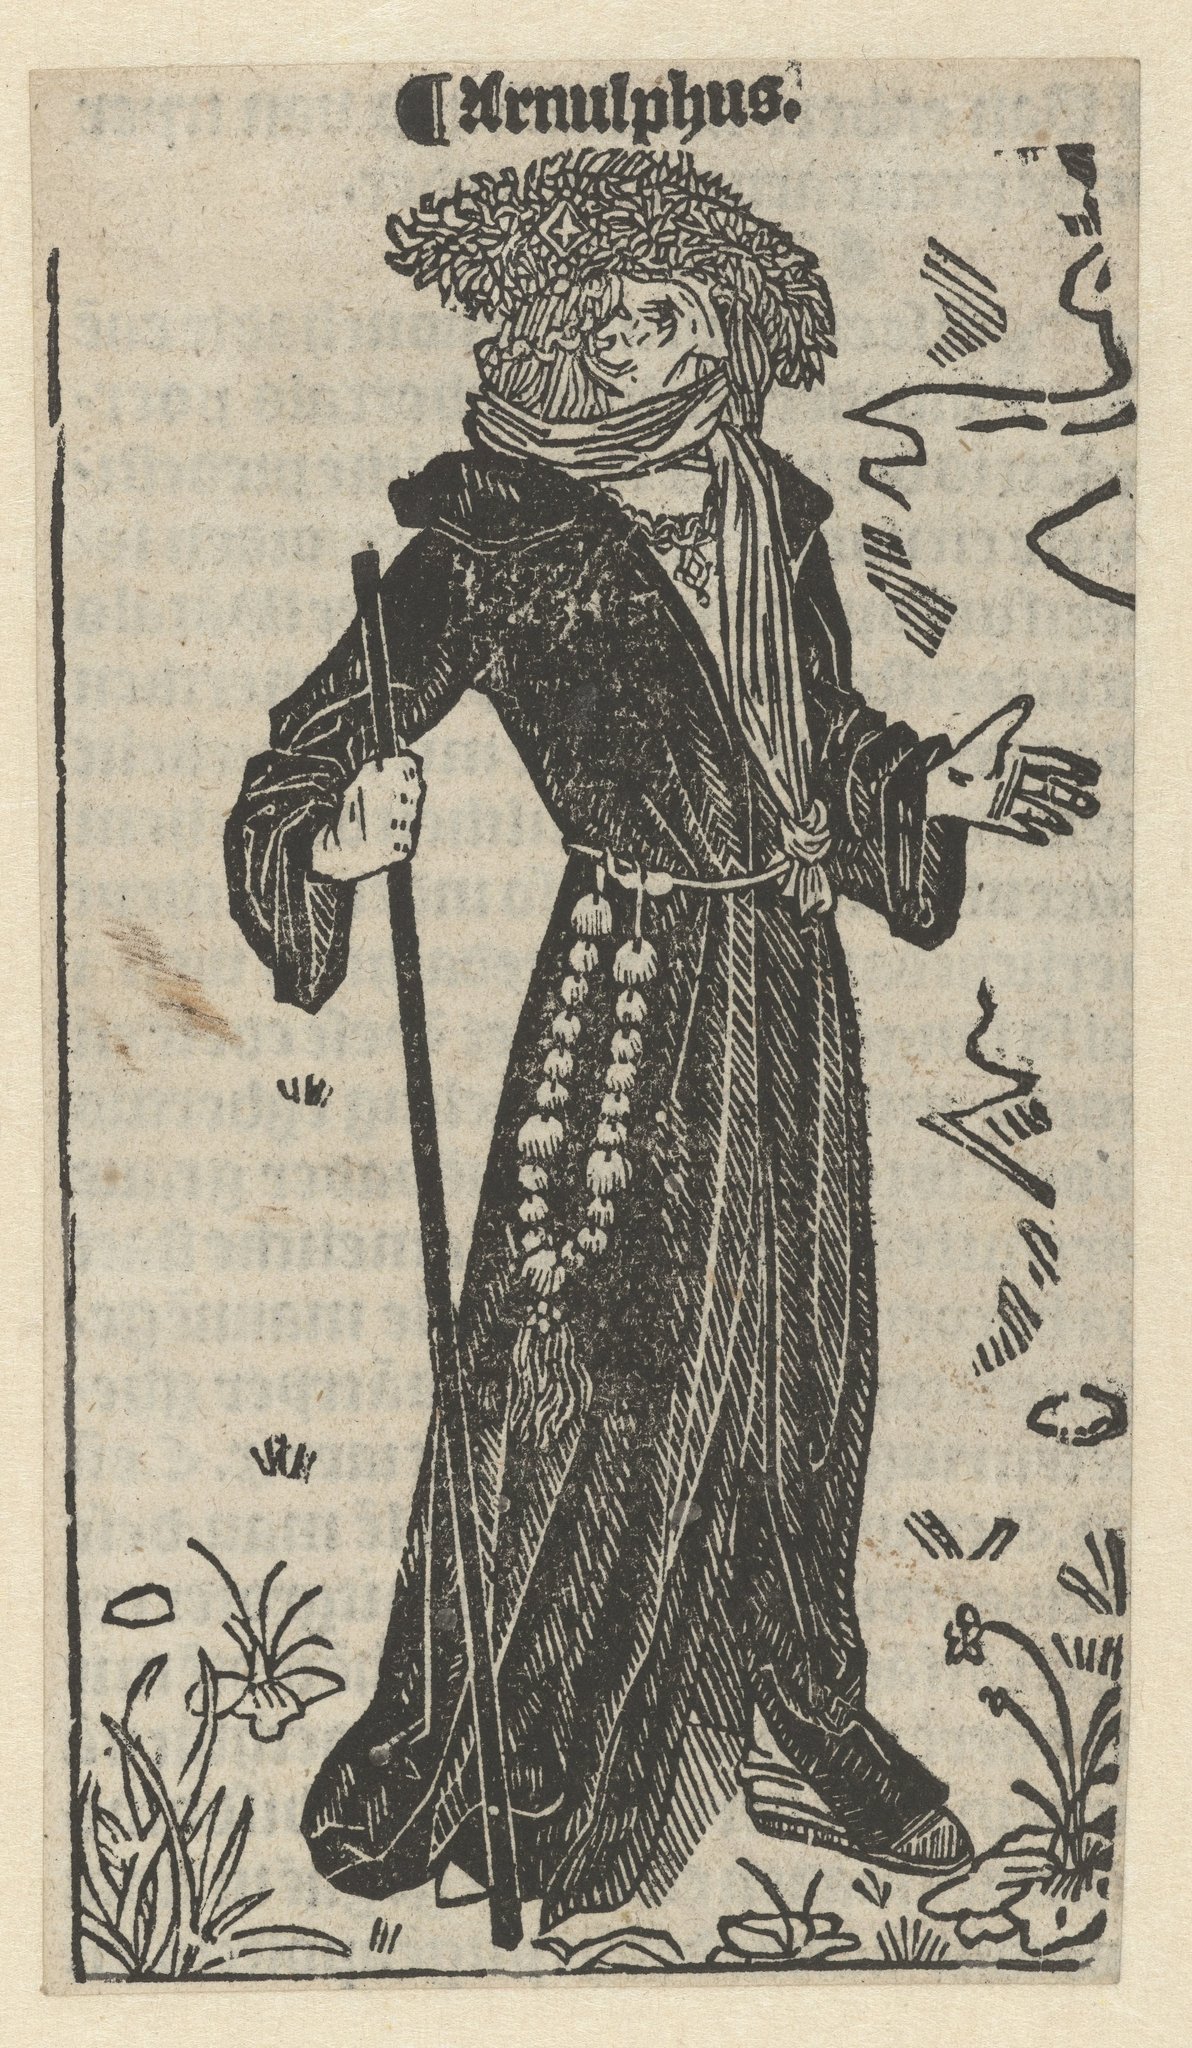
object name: book illustration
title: Arnulphus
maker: Anonymous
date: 1517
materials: paper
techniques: woodcut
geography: low countries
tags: ghent, head-gear: hat (+ men's clothes), (scenes from) specific works of literature (with author, title), male literary characters (with name)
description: Late afdruk van de versneden houtblokken van Le Chevalier déliberé van Olivier de la Marche (Gouda 1486). Eén blad van veertien uit Cronycke van Hollandt, uitgegeven door Jan Seversz, te Leiden in 1517 en 1530. Uit blad 2 , l'acteur.